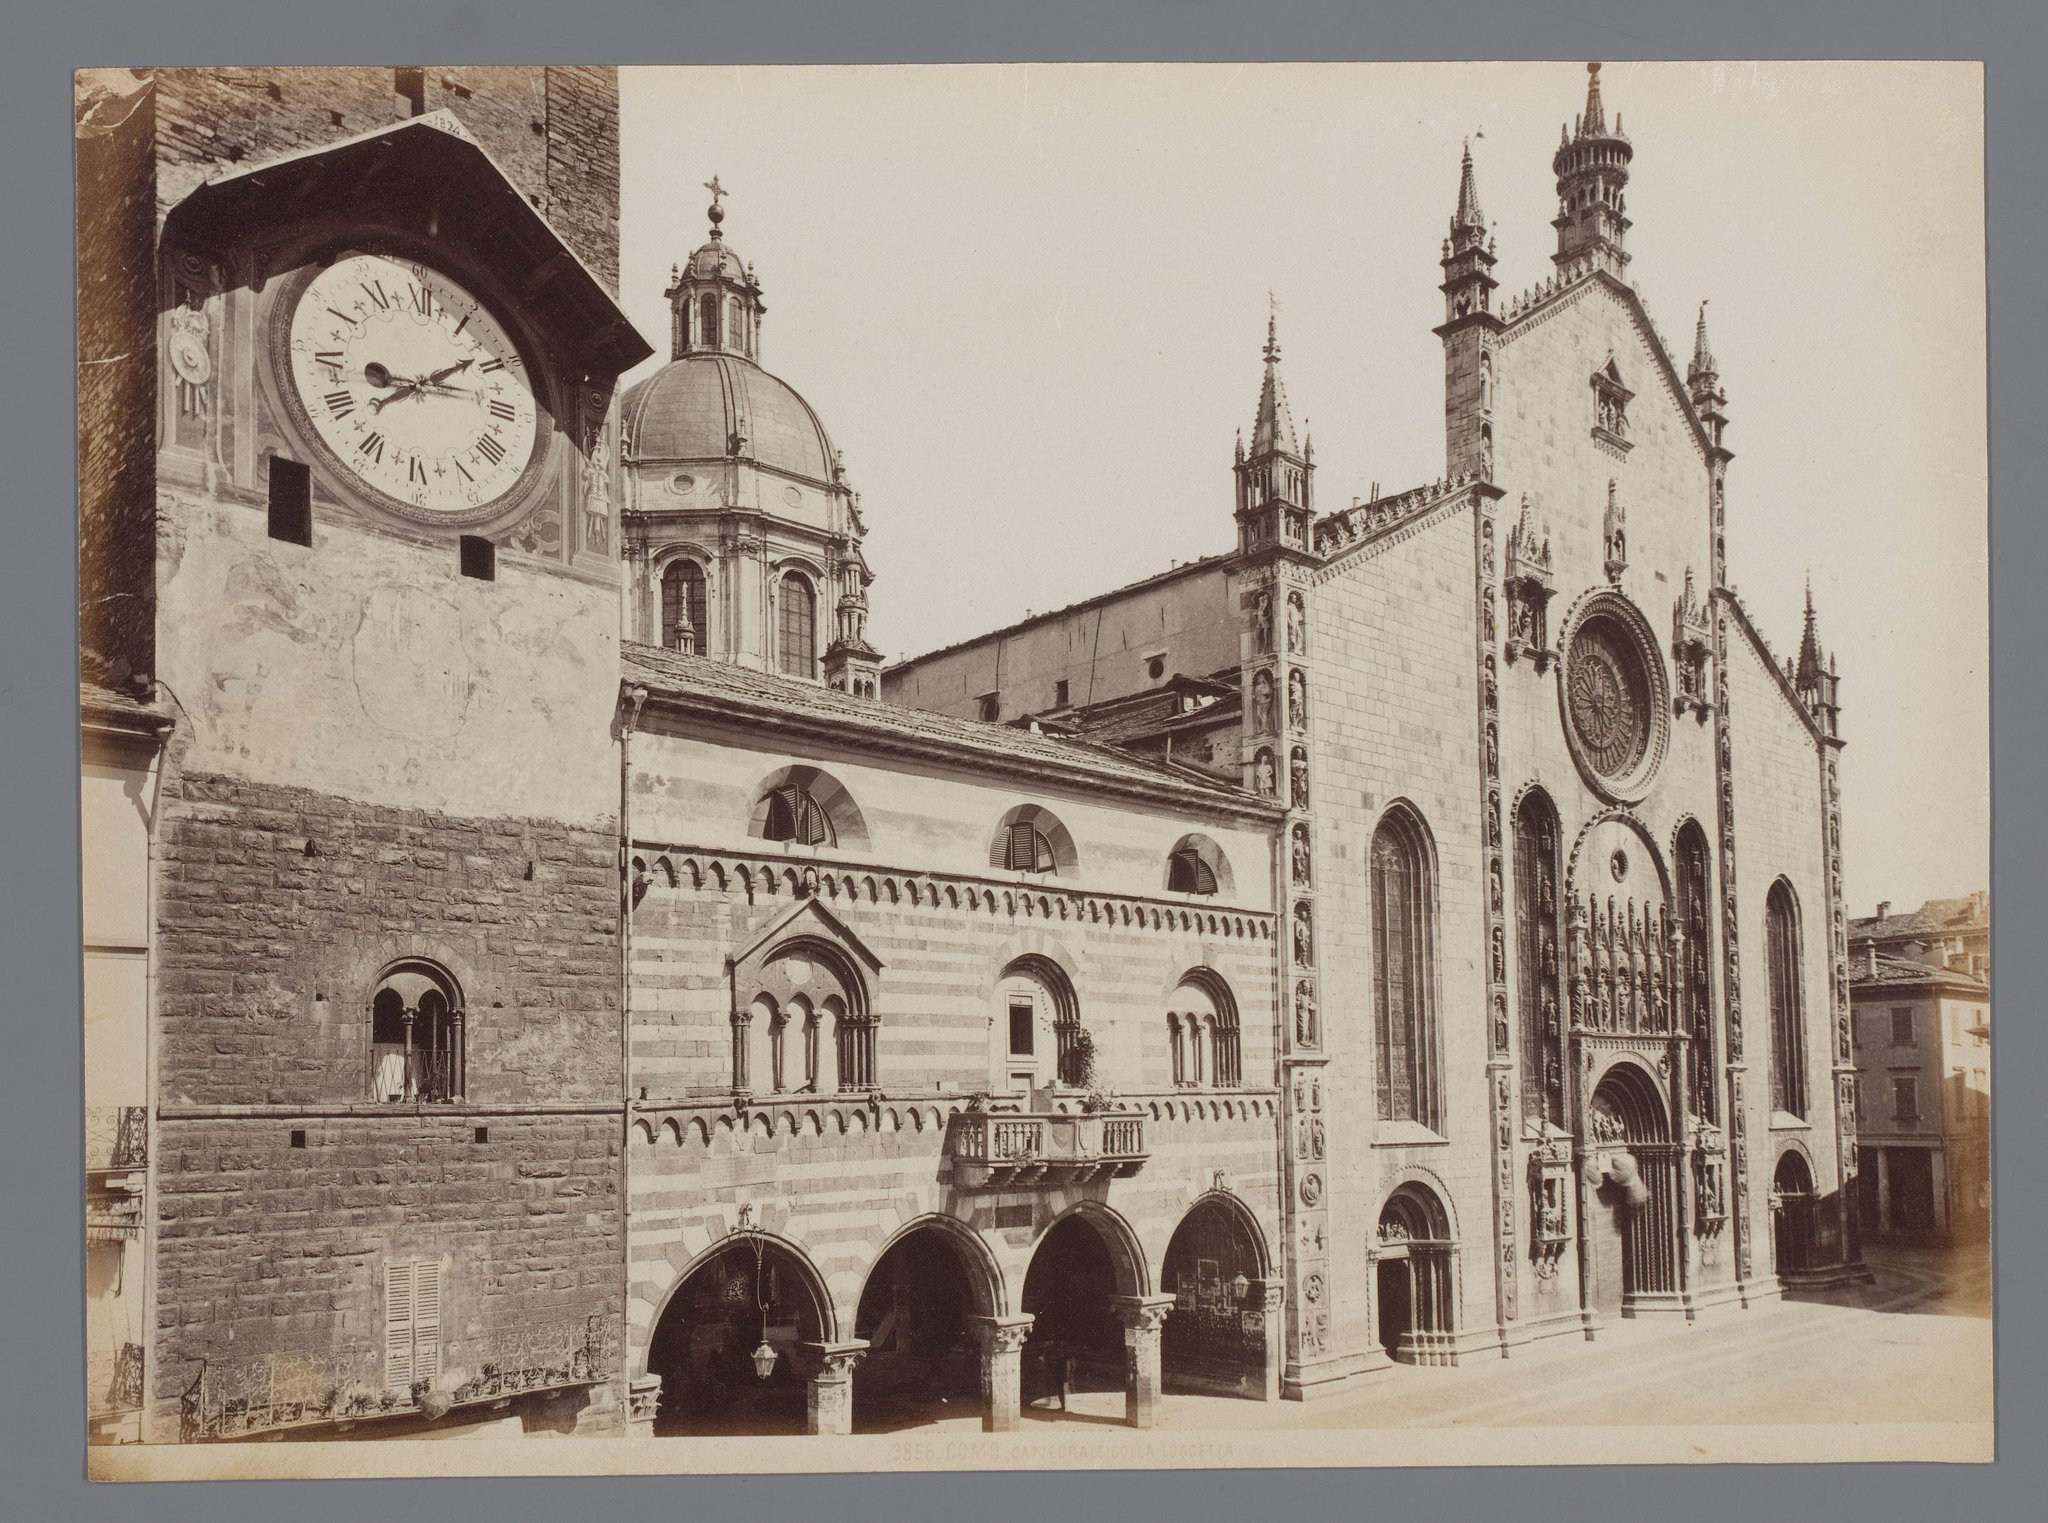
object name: photograph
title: Kerk met dom en klokketoren, Italië [?]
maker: Anonymous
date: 1880-1900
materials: paper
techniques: albumen print